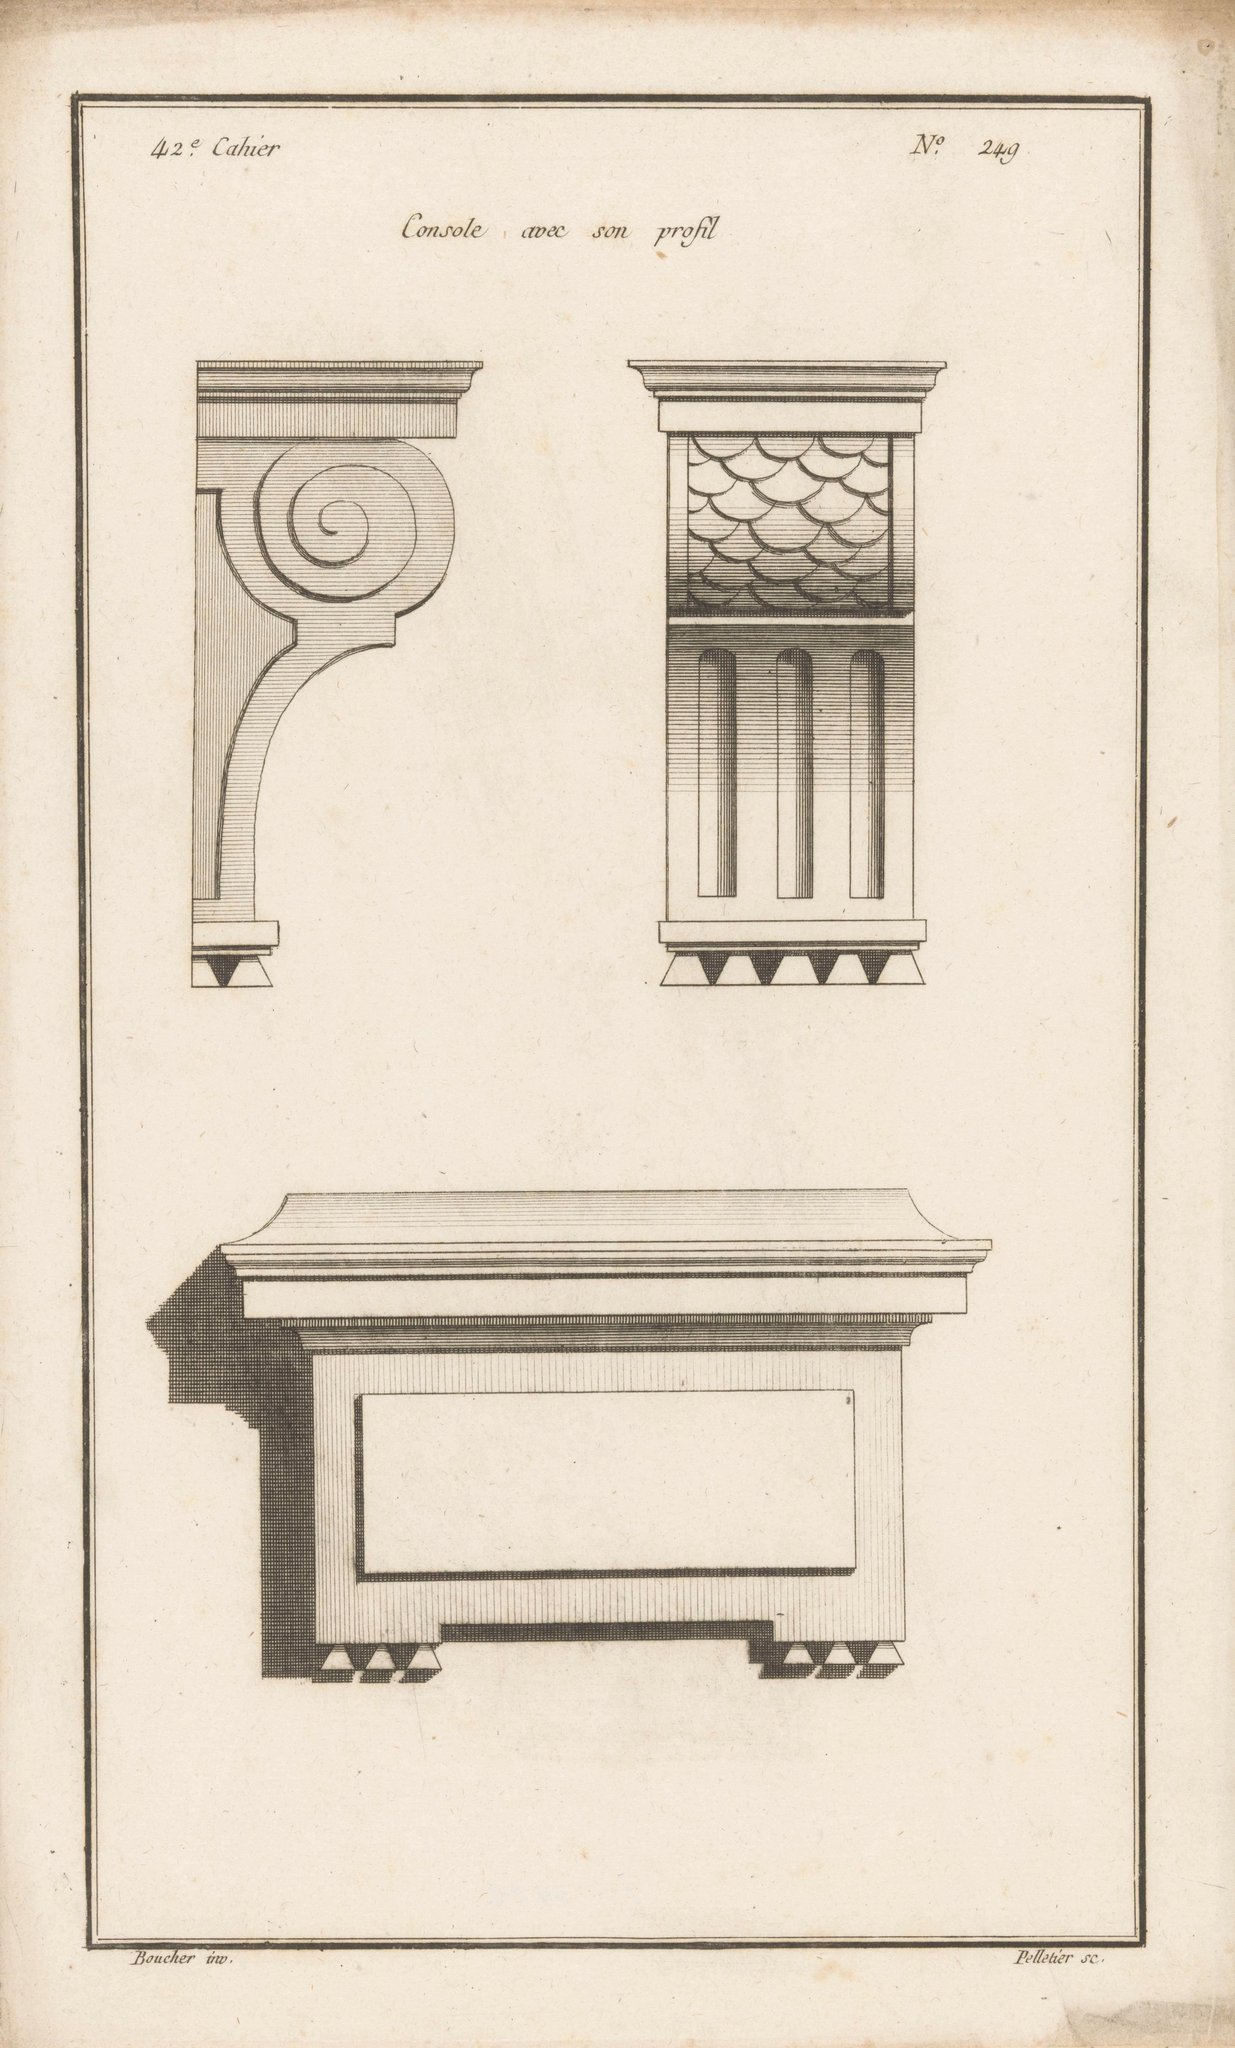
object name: ornament print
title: Console avec son profil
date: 1772-1779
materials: paper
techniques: engraving, etching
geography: paris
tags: ornament ~ spiral and derived from spiral, e.g.: greek wave, other architectural details (console)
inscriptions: collector's mark: Lugt 2228, collector's mark: Lugt 2760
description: Zij- en vooraanzicht van een console met een voluut. Daaronder een architectuurfragment met een tablet. Prentnummer 249.